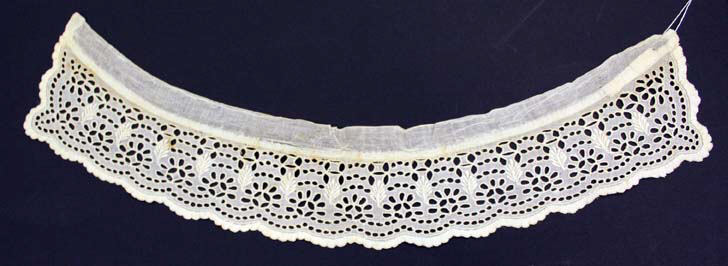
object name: collar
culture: american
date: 1850-1869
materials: cotton